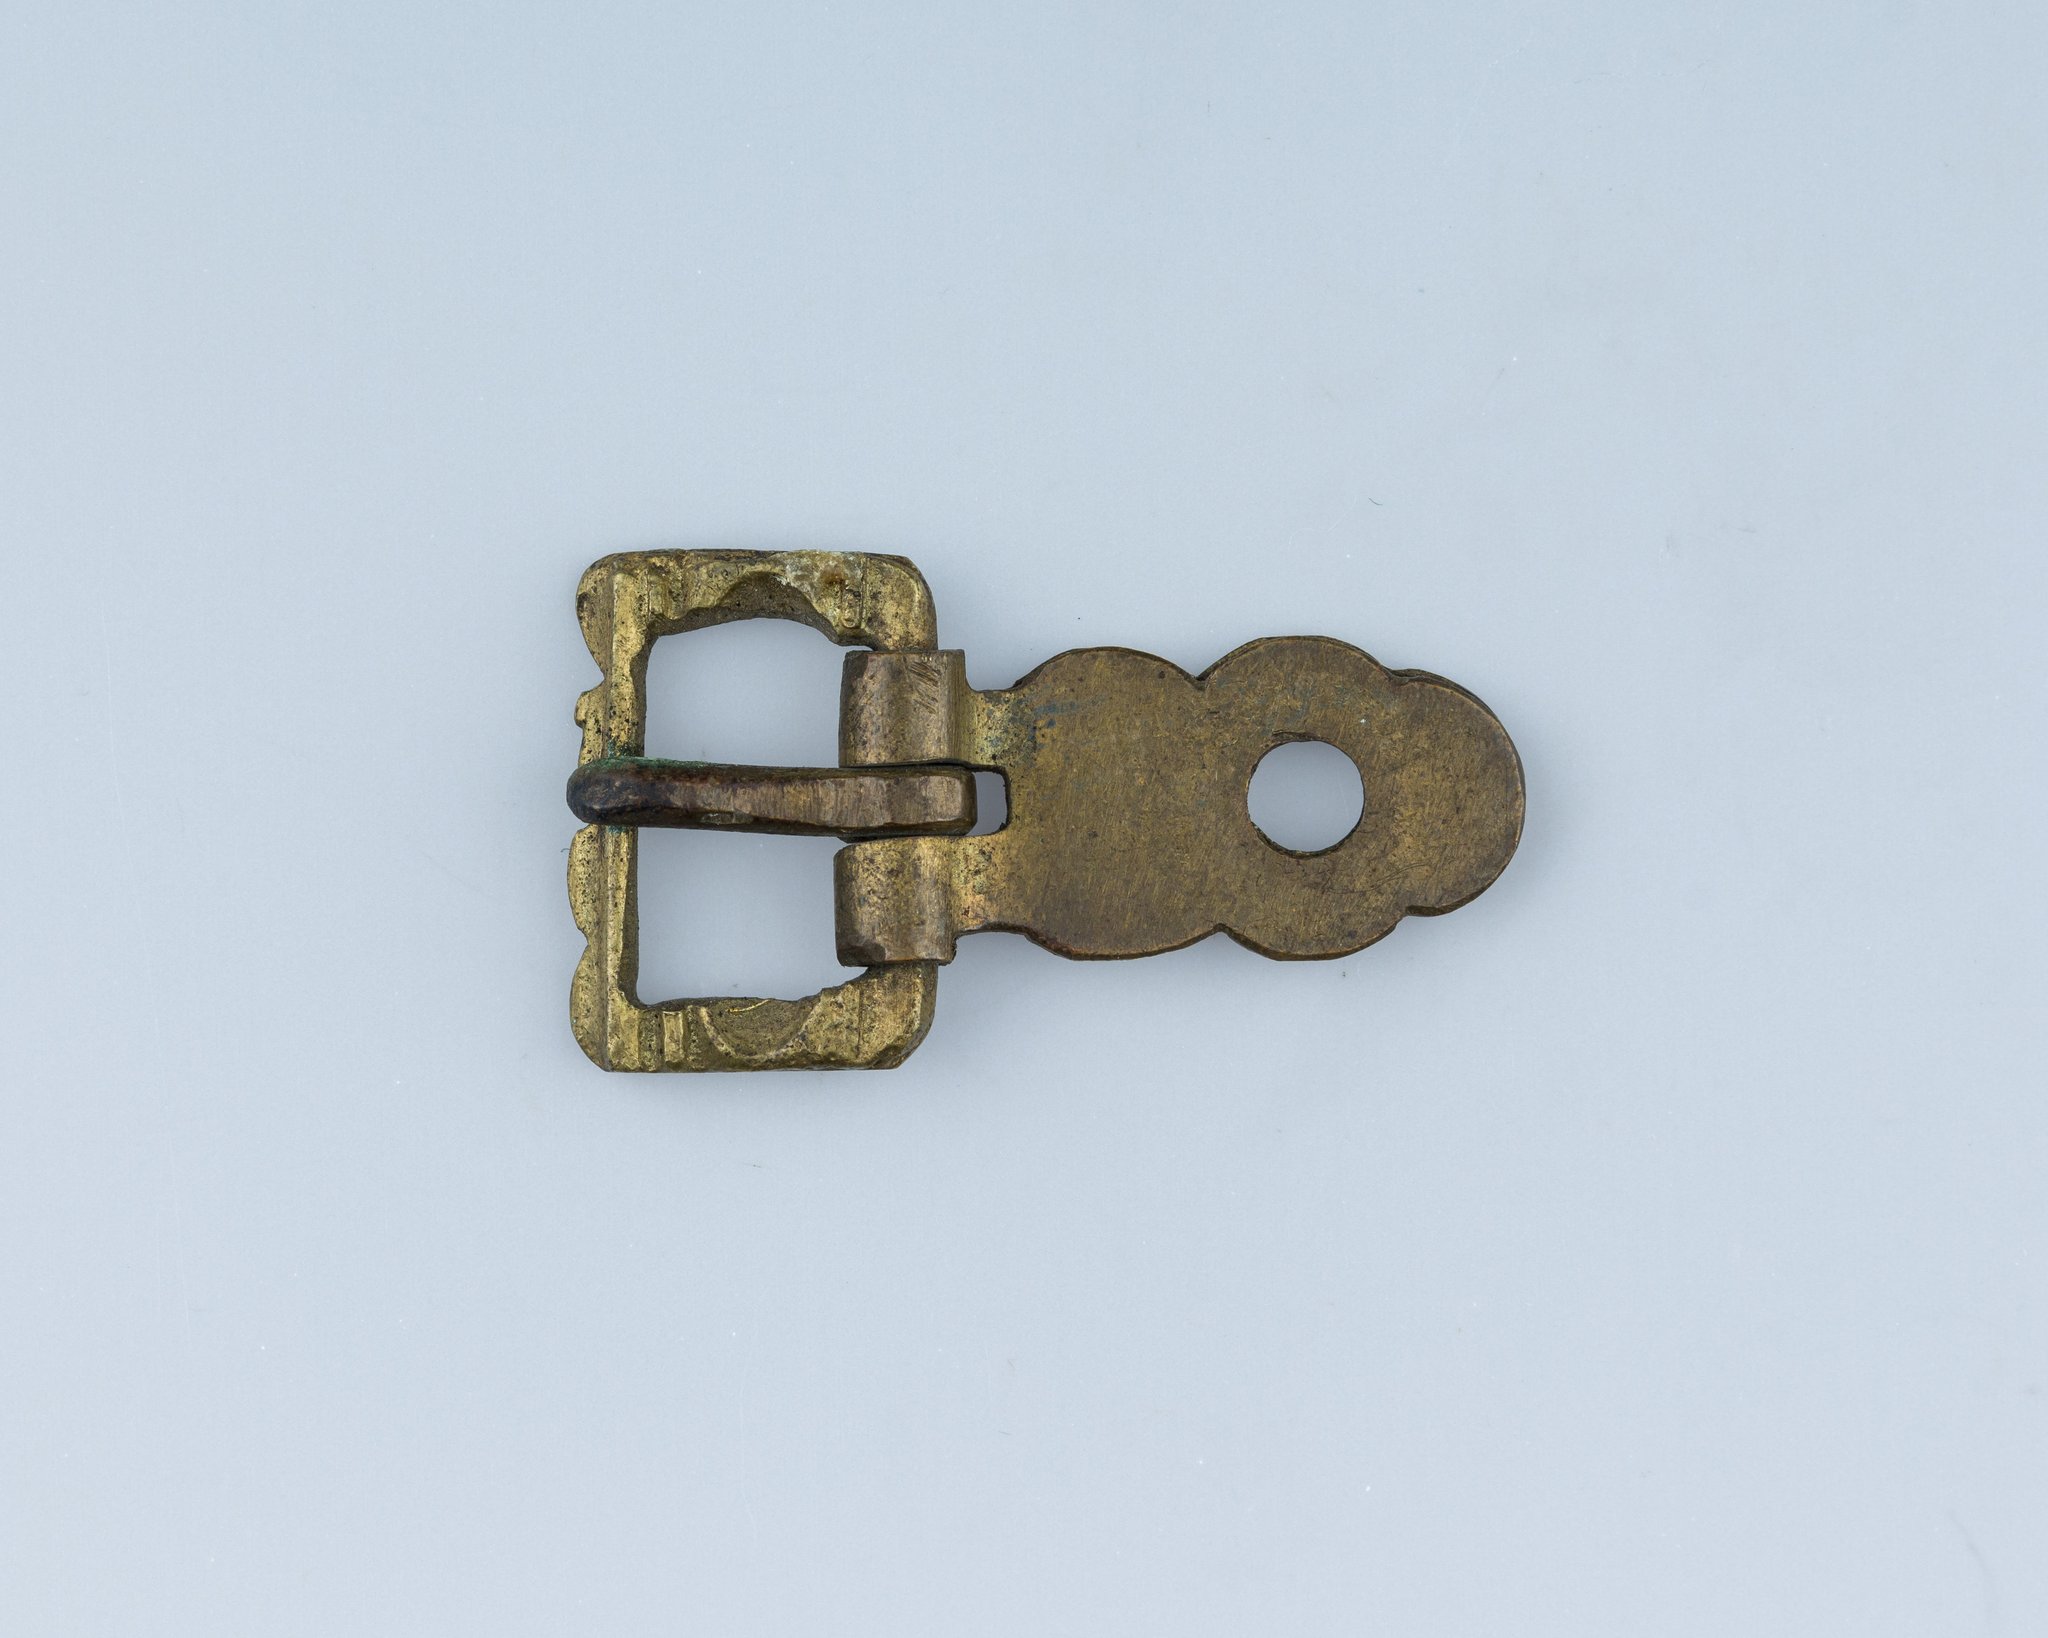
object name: buckle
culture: german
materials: brass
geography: germany